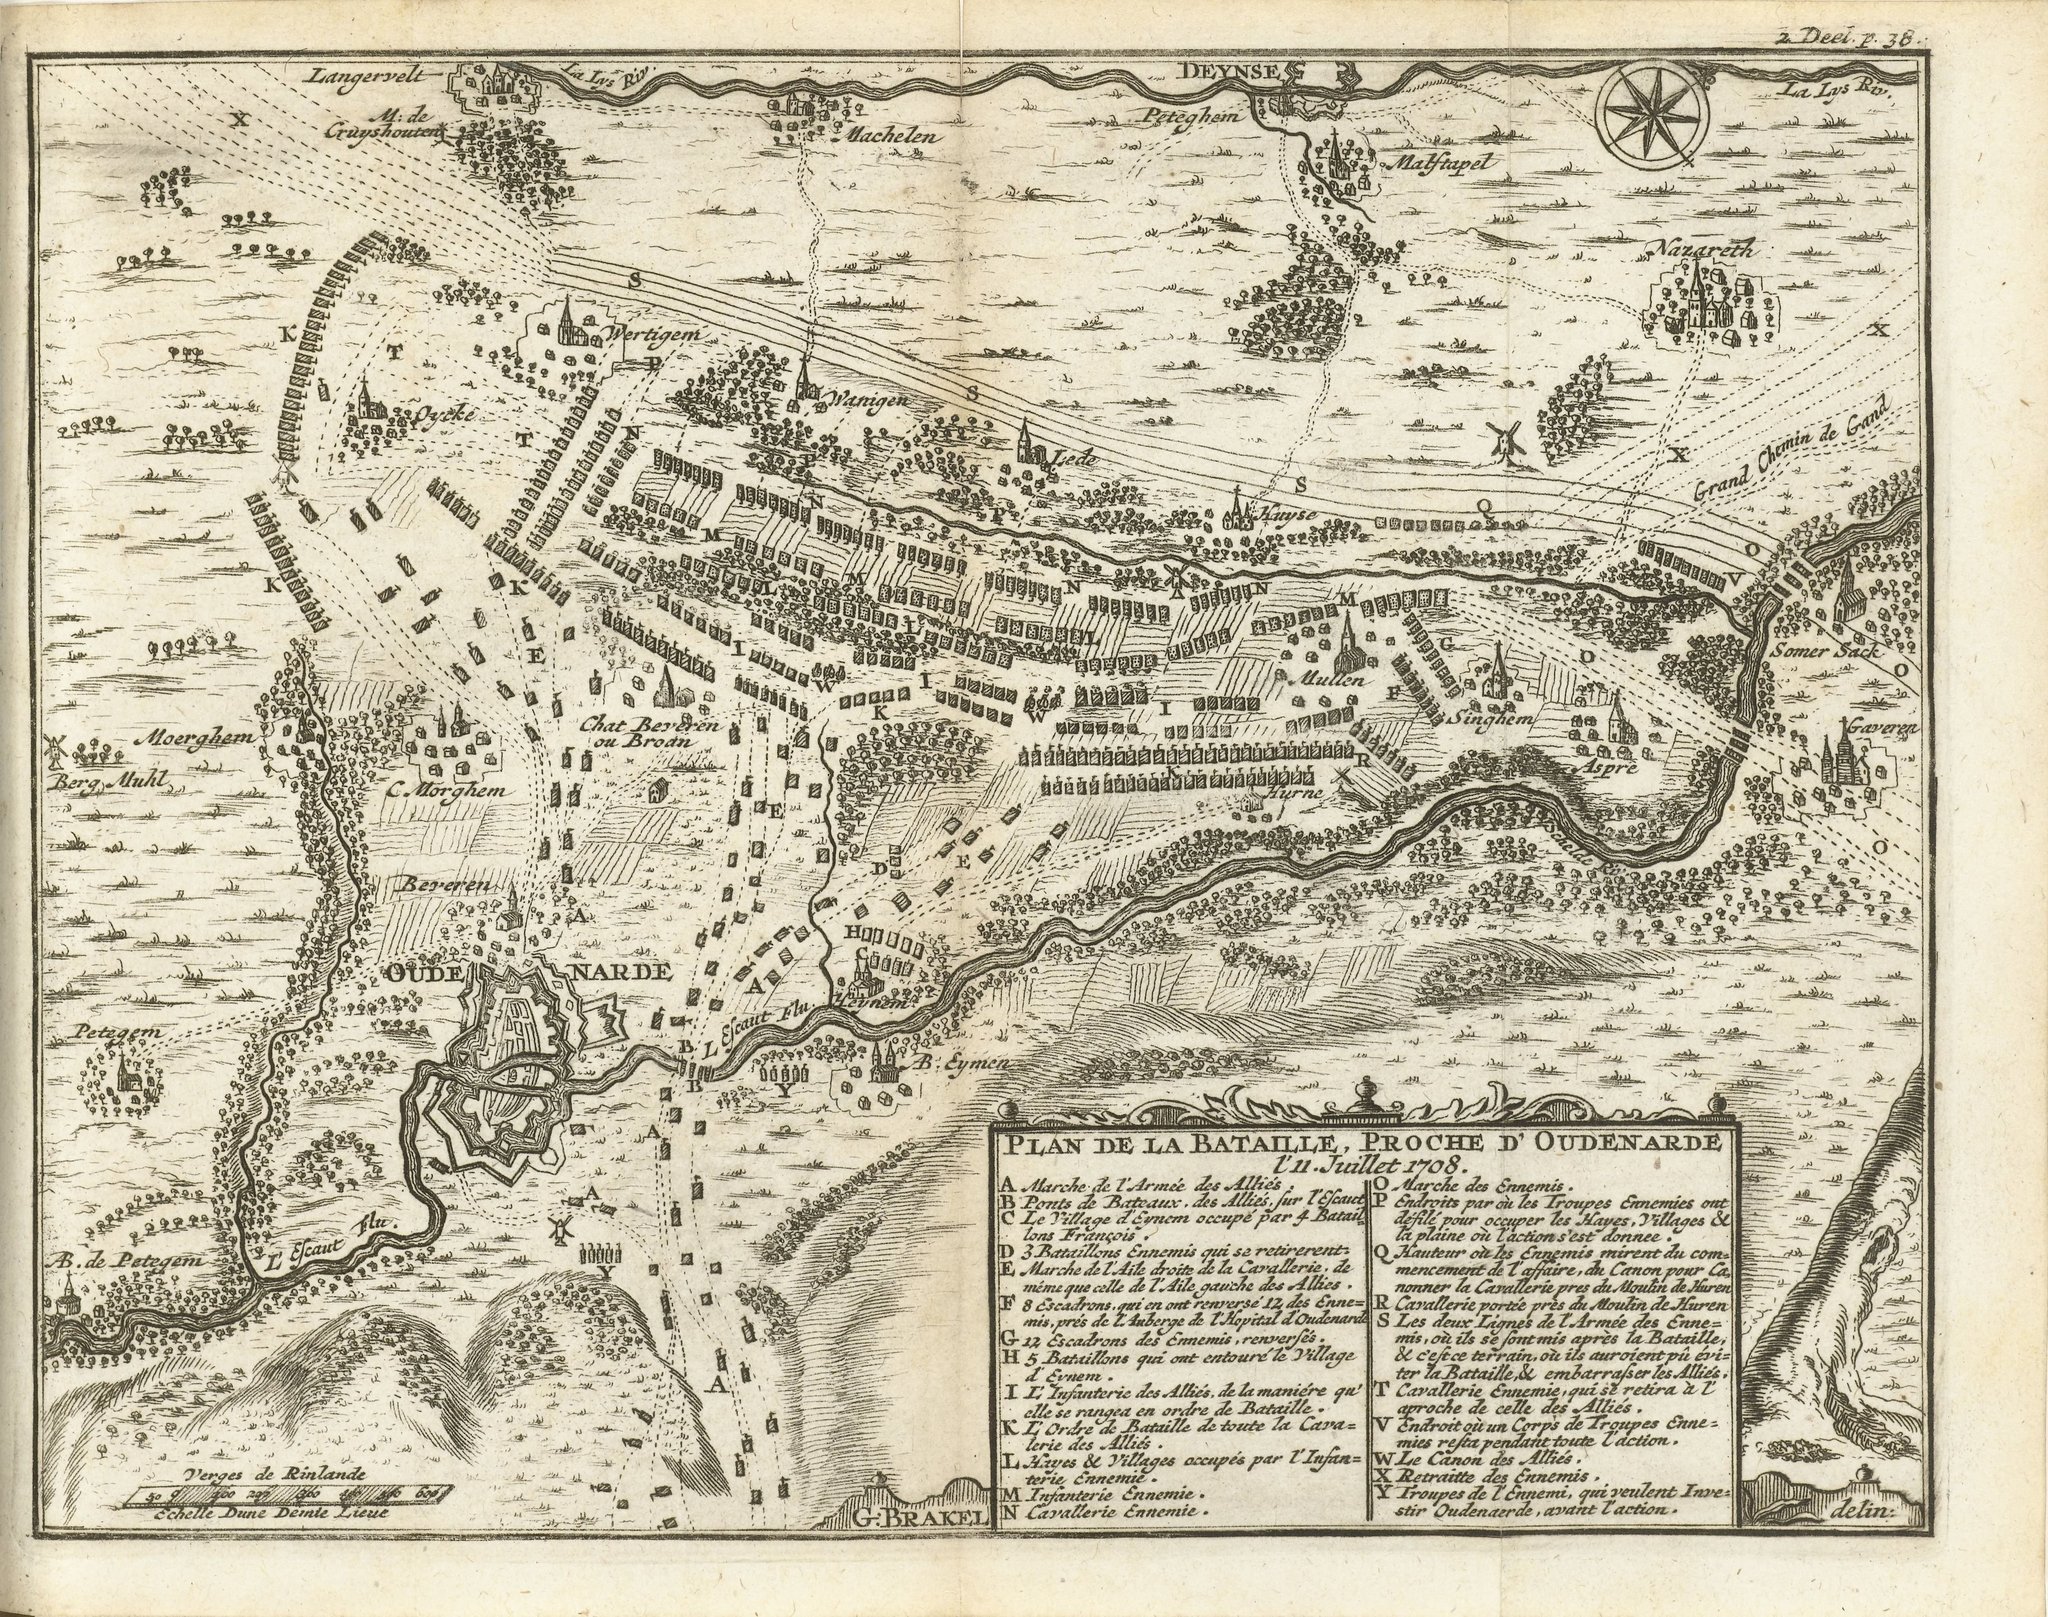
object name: print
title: Plan de la Bataille, proche d'Oudenarde l'11. Juillet 1708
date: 1714-1716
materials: paper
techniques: etching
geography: amsterdam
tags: johan willem friso (prins van oranje-nassau), maps of separate countries or regions, battle (+ land forces)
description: Kaart van de slag bij Oudenaarde tussen het Franse leger en de geallieerden, 11 juli 1708. Illustratie in de Nederlandse vertaling uit 1716 van J. Lamigue, Het leven van Zyne Hoogheit Johan Willem Friso, dl. II, p. 38/39.